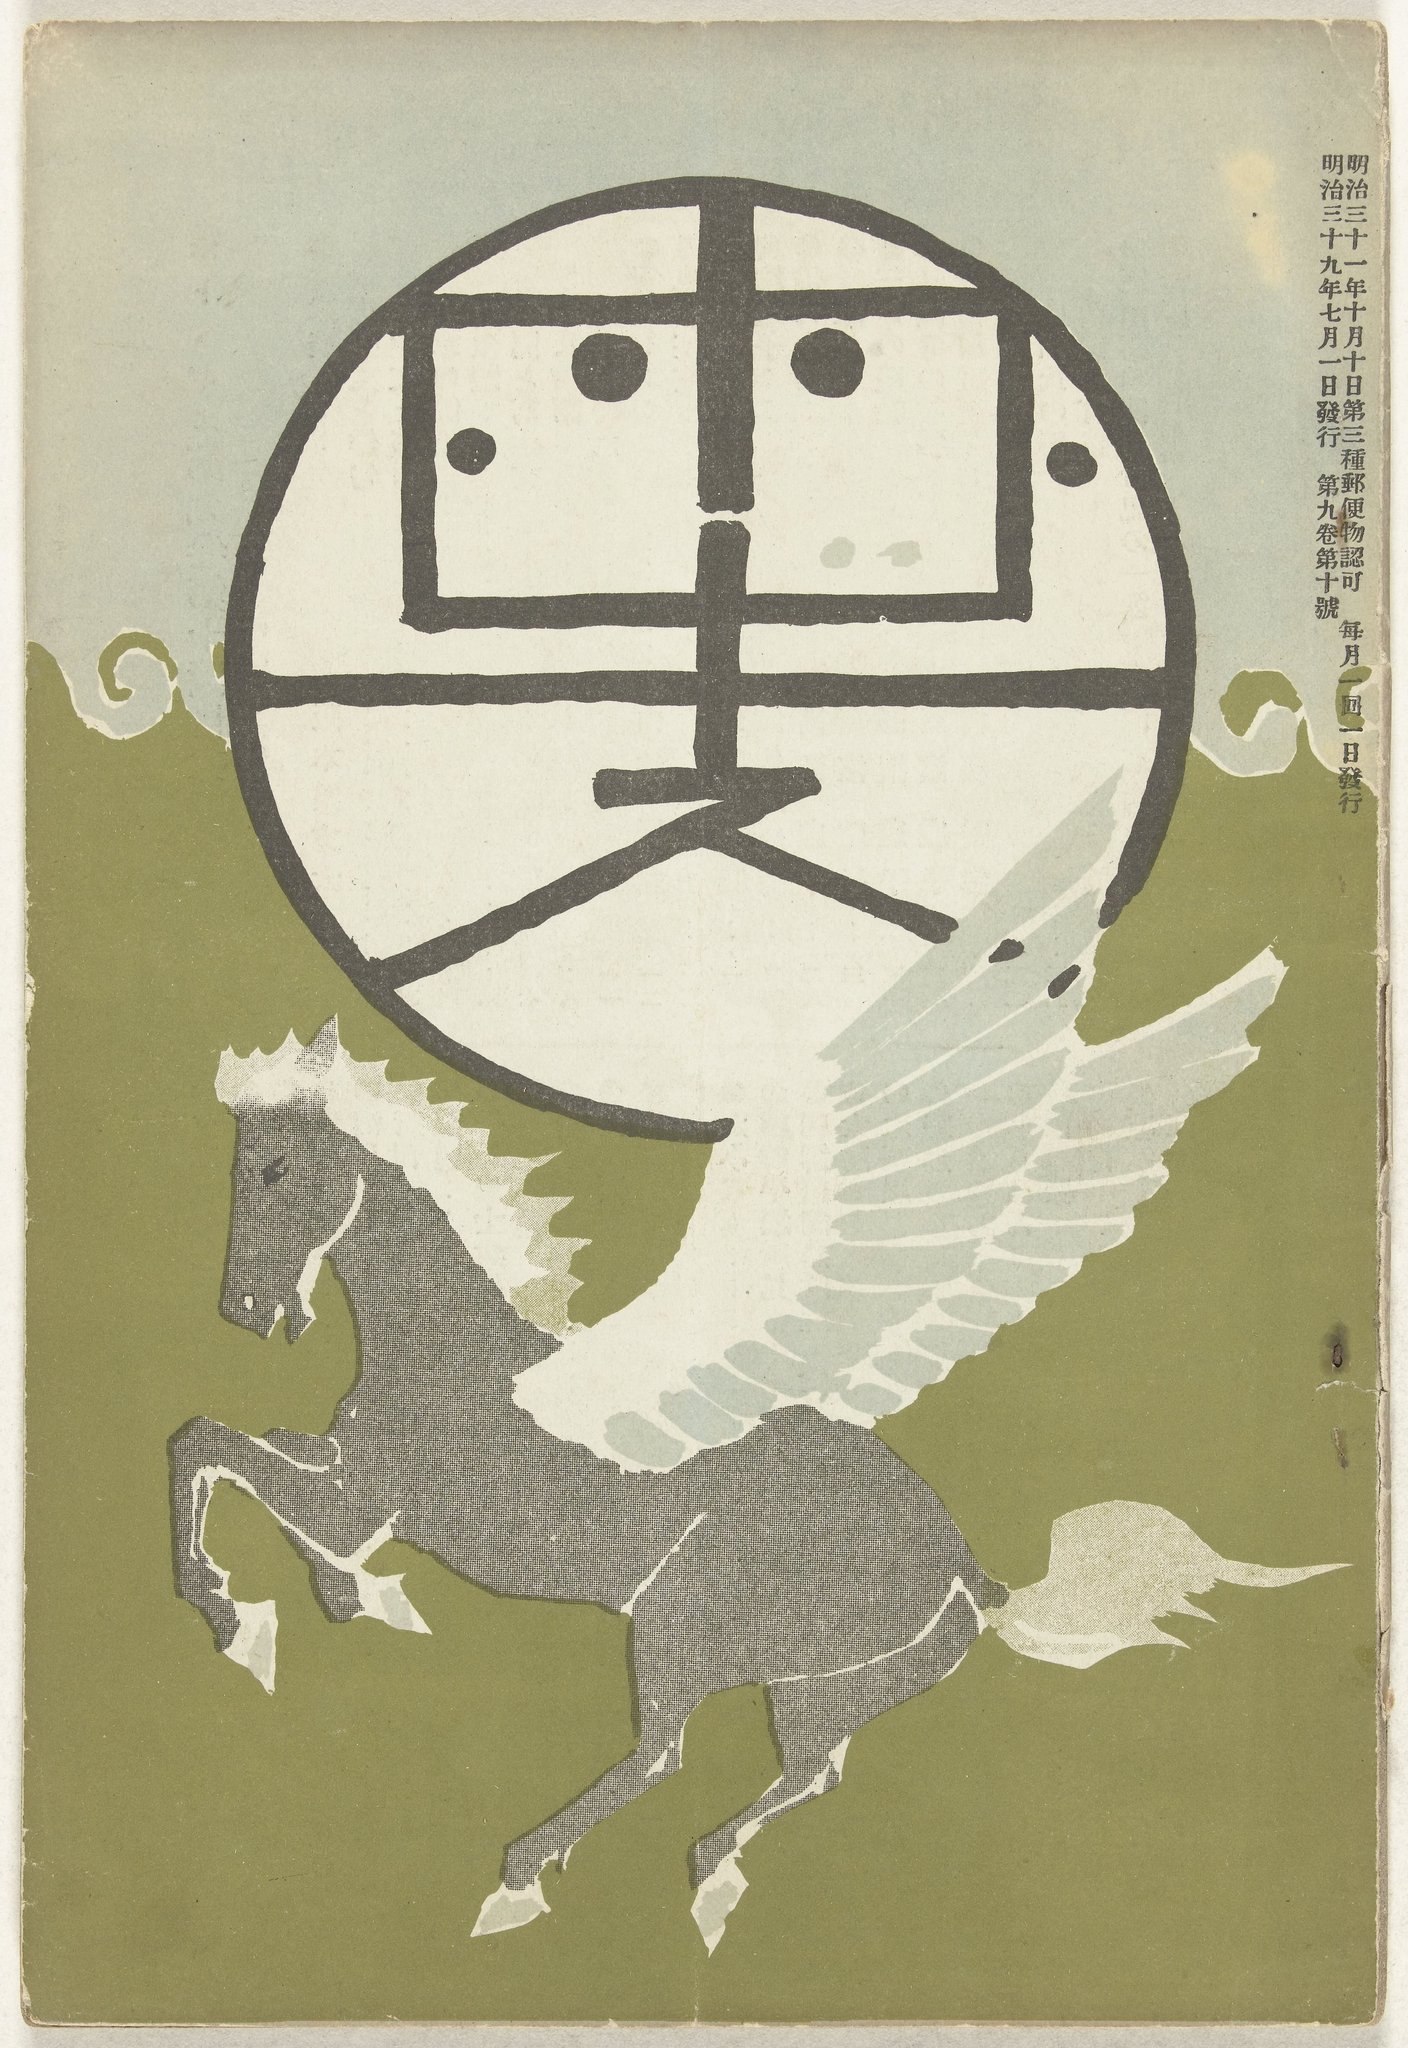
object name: book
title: Hototogisu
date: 1906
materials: paper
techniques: woodcut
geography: japan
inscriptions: date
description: Nummer 10 van jaargang 9 (juli 1906) van het literaire maandblad Hototogisu: kaft met afbeelding van gevleugeld paard tegen groene achtergrond met lichtblauwe lucht; achterkant, afbeelding van waterlelies en vissen.